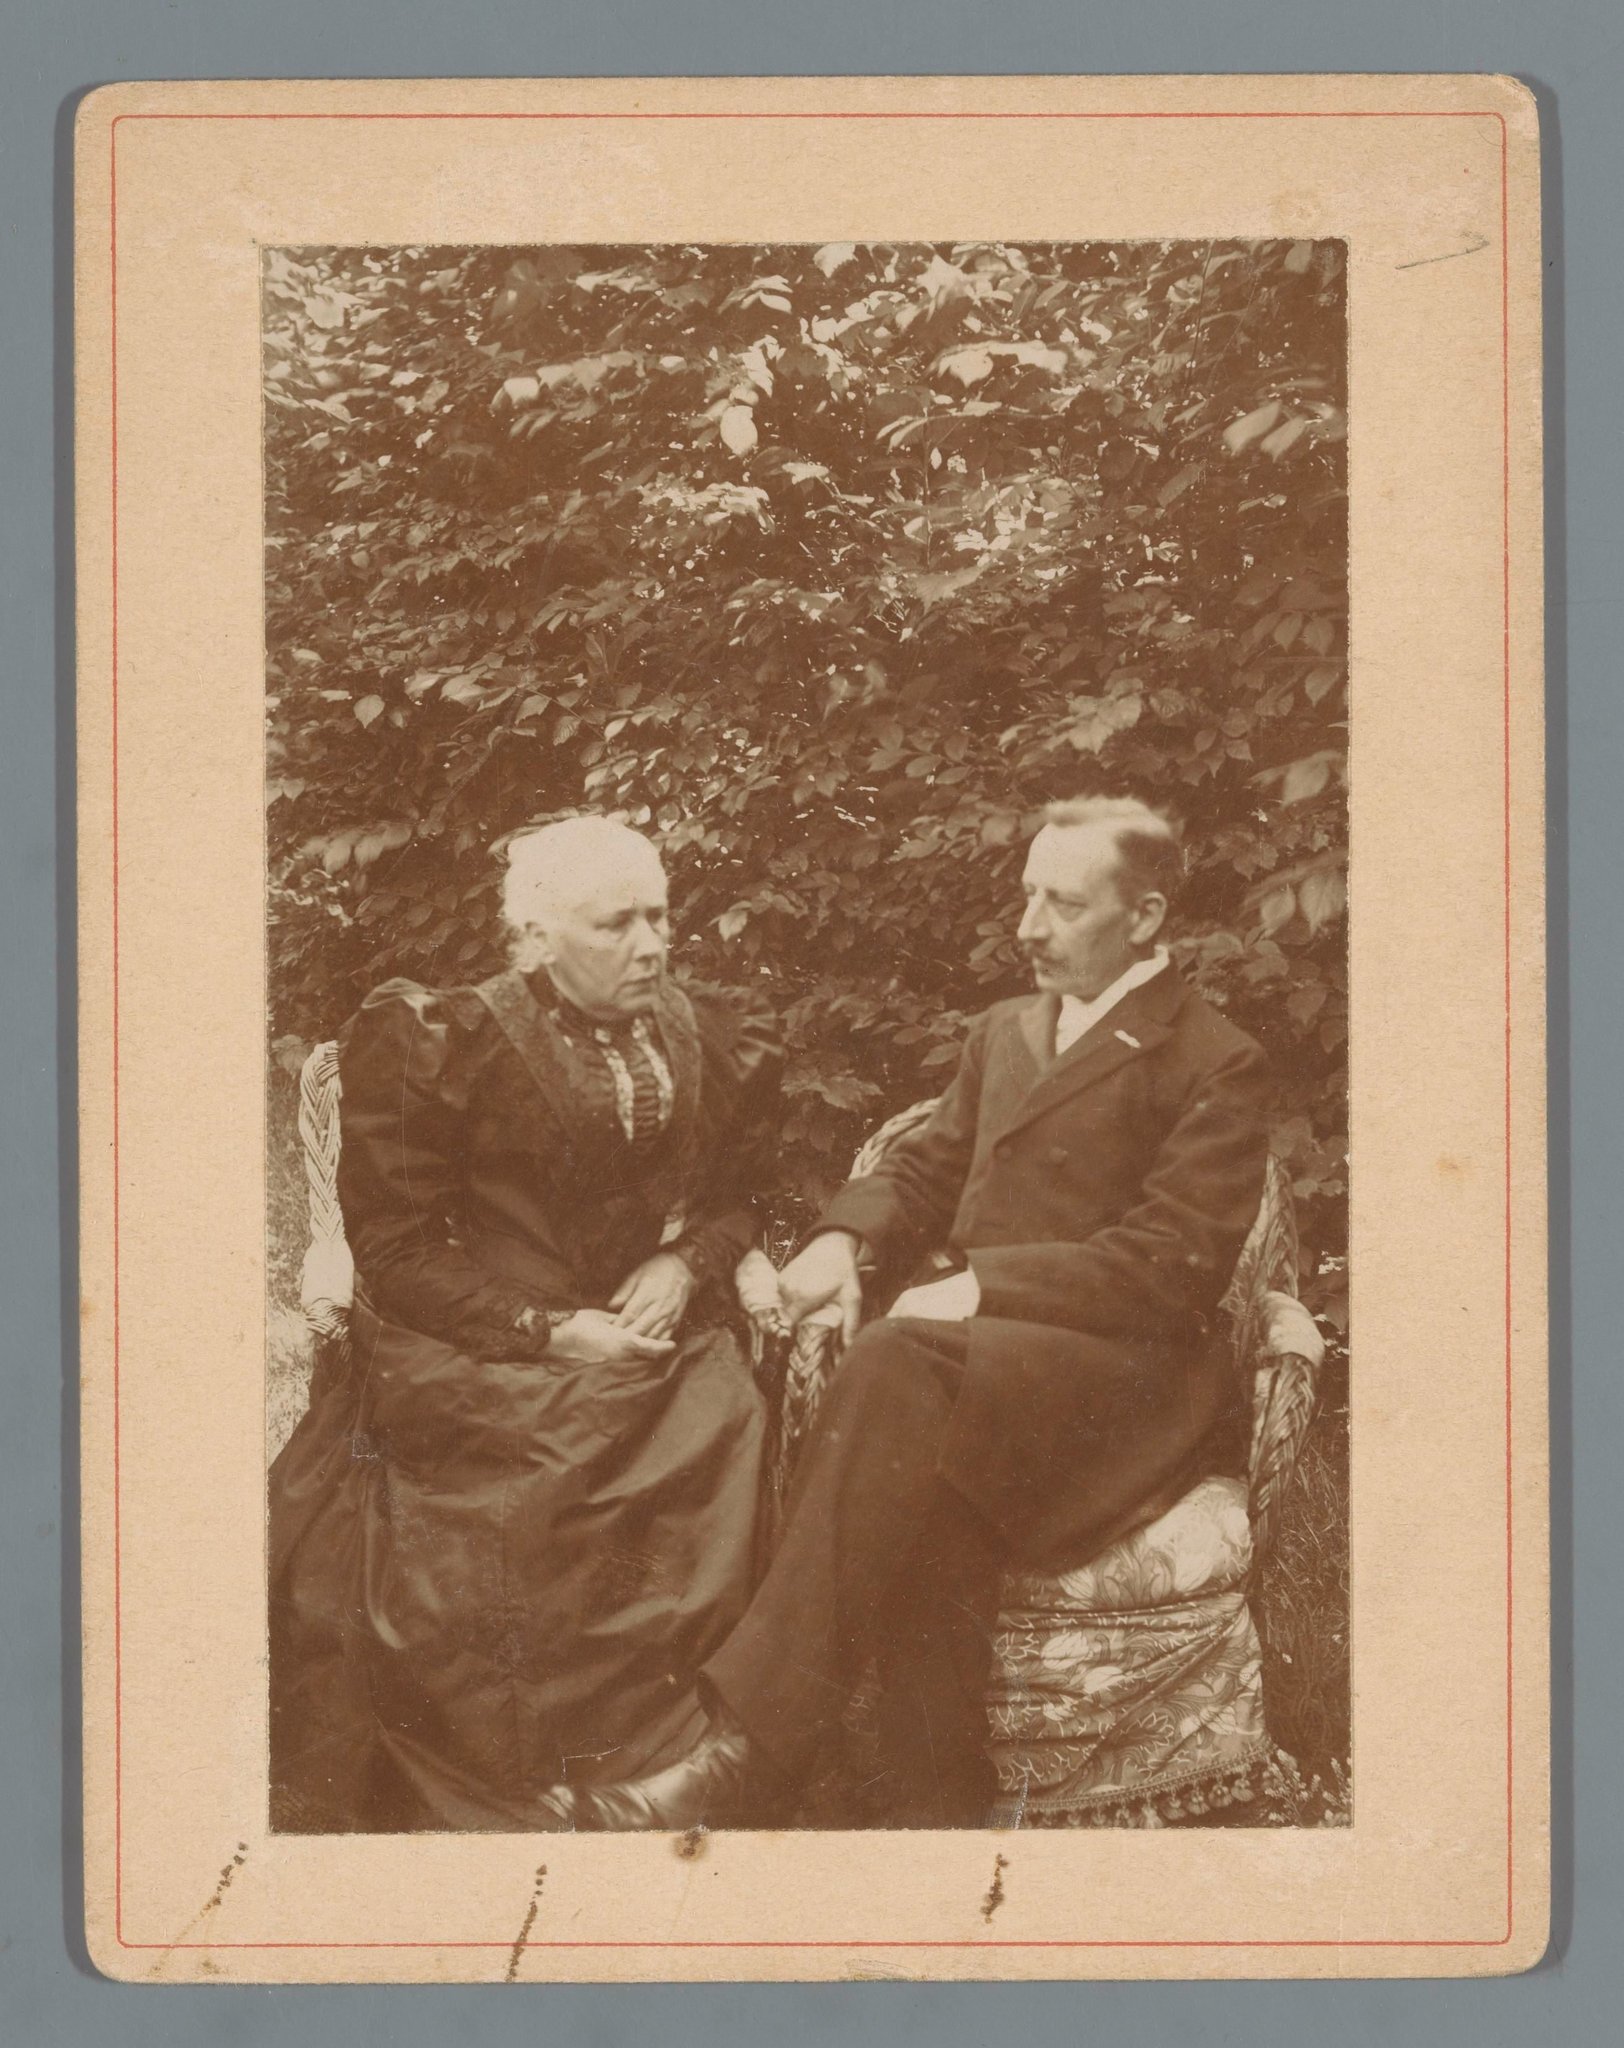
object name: photograph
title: Portret van een ouder echtpaar in een tuin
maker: Anonymous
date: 1900-1915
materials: cardboard, photographic support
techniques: collodion silver print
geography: netherlands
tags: garden, old man, old woman